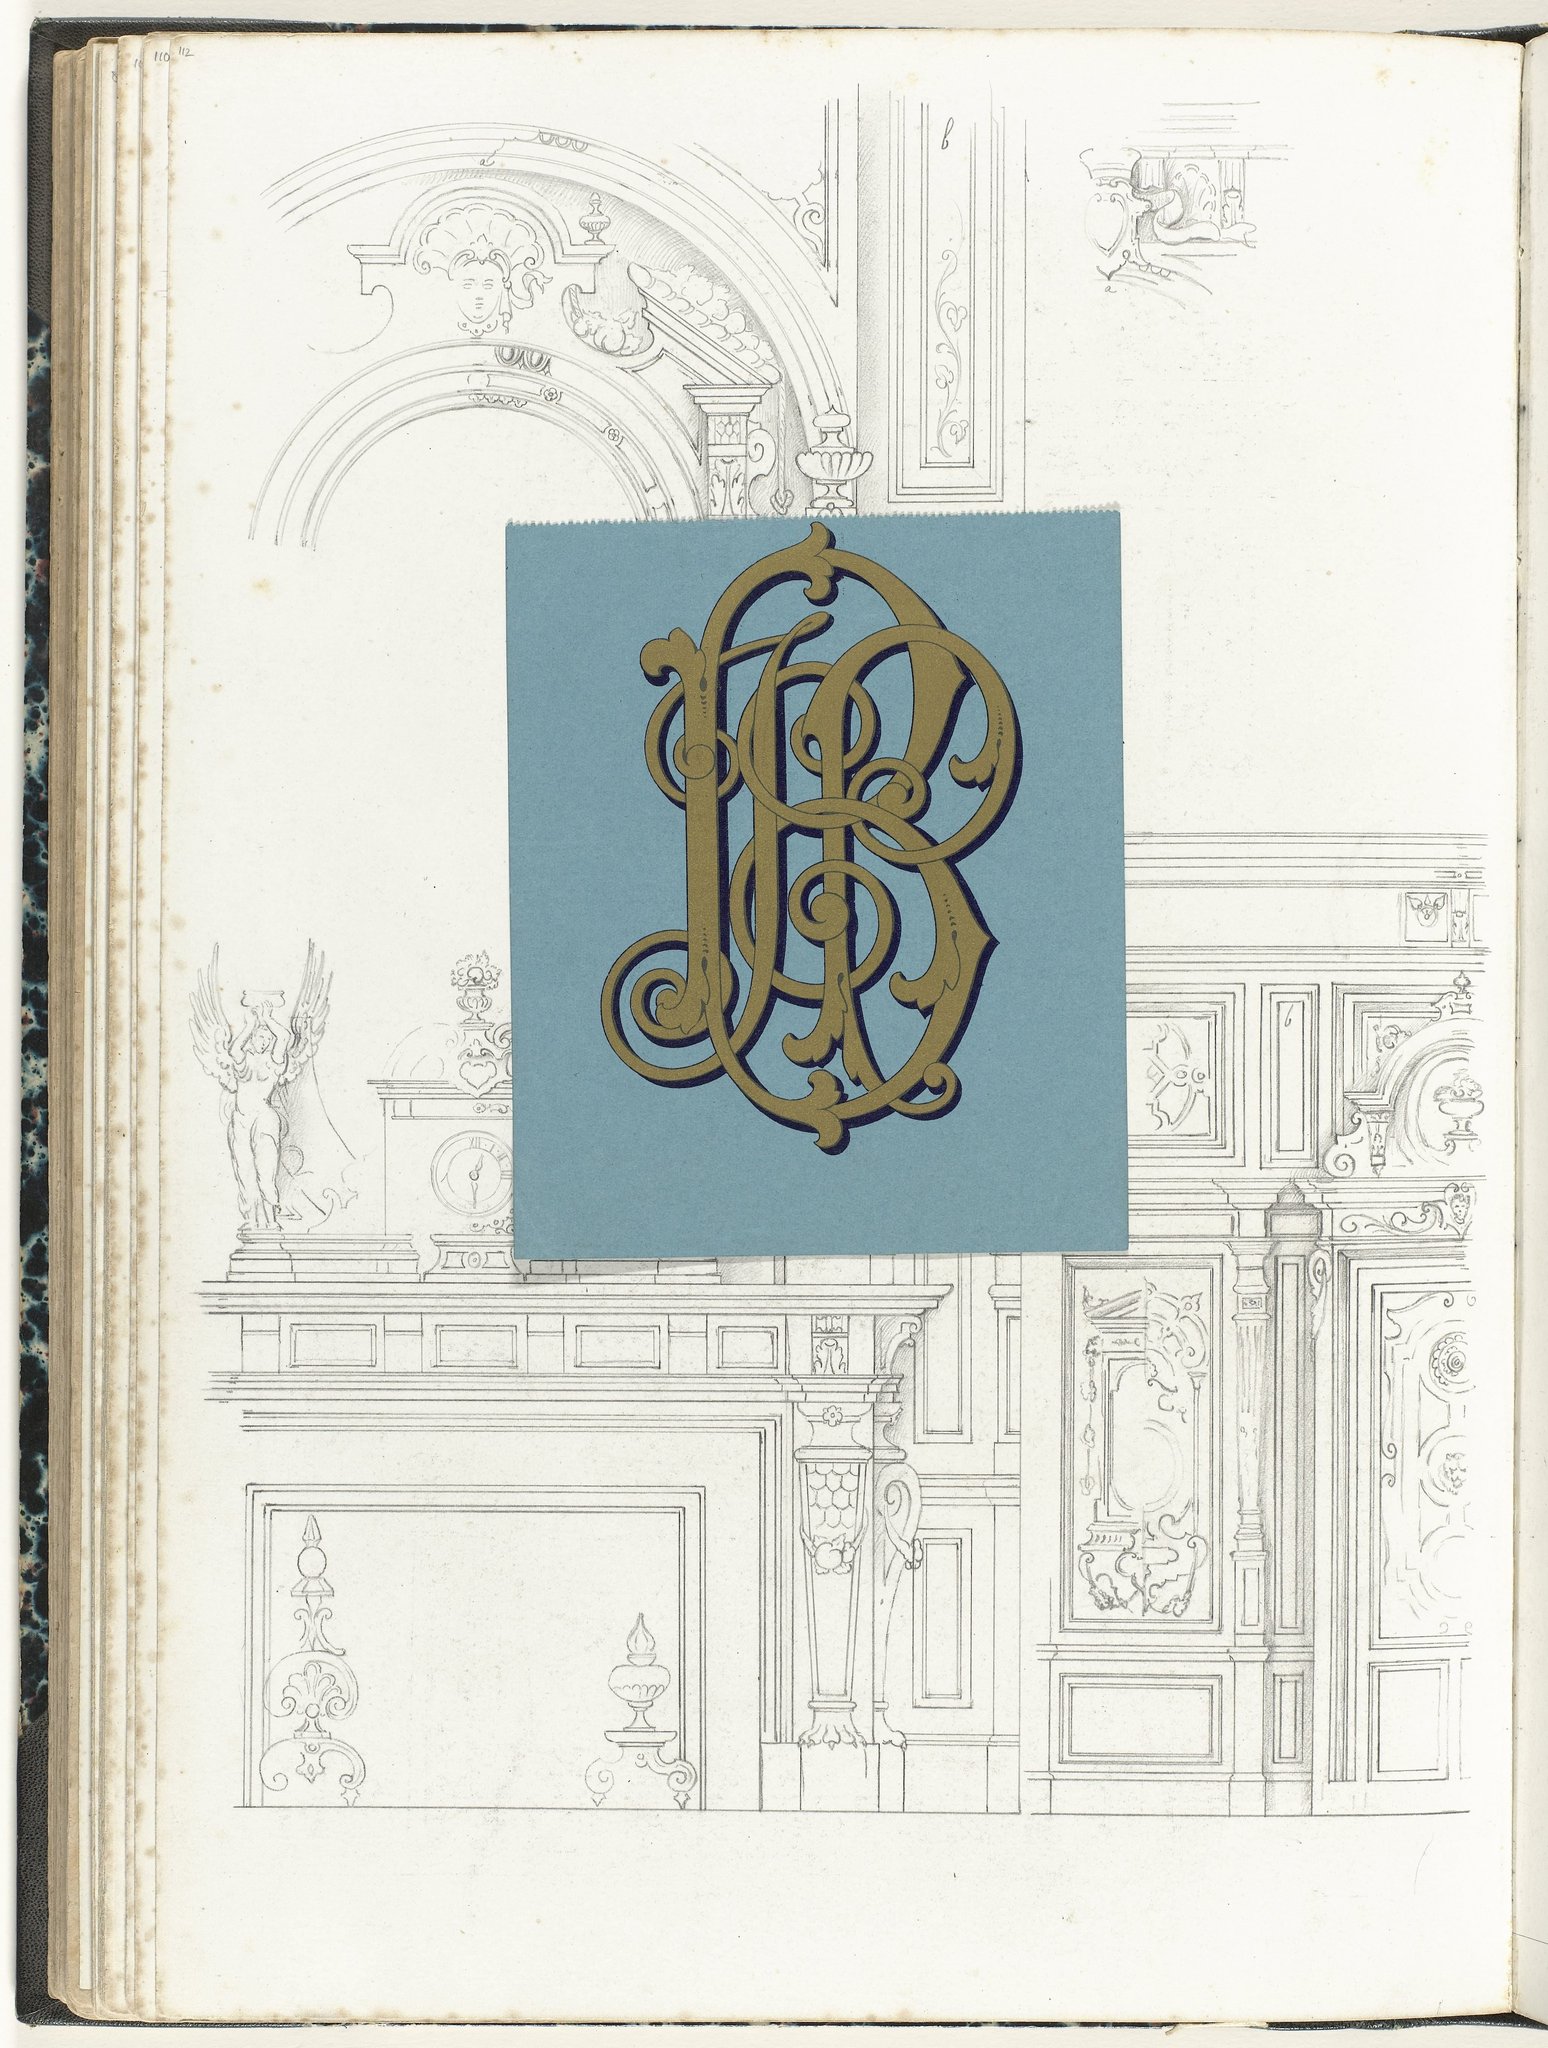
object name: print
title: Monogram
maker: Anonymous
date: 1866-1900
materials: paper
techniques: lithograph